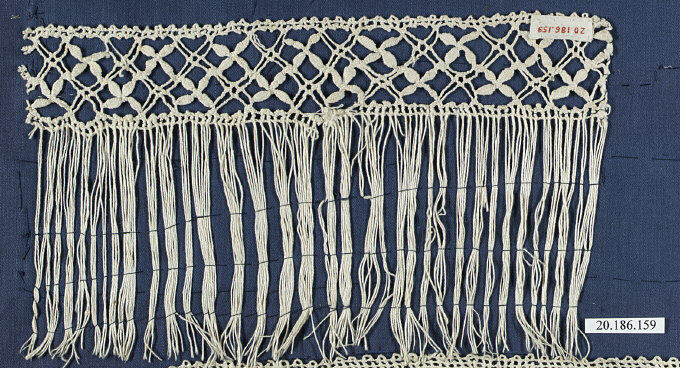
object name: border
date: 1601-1700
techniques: lace